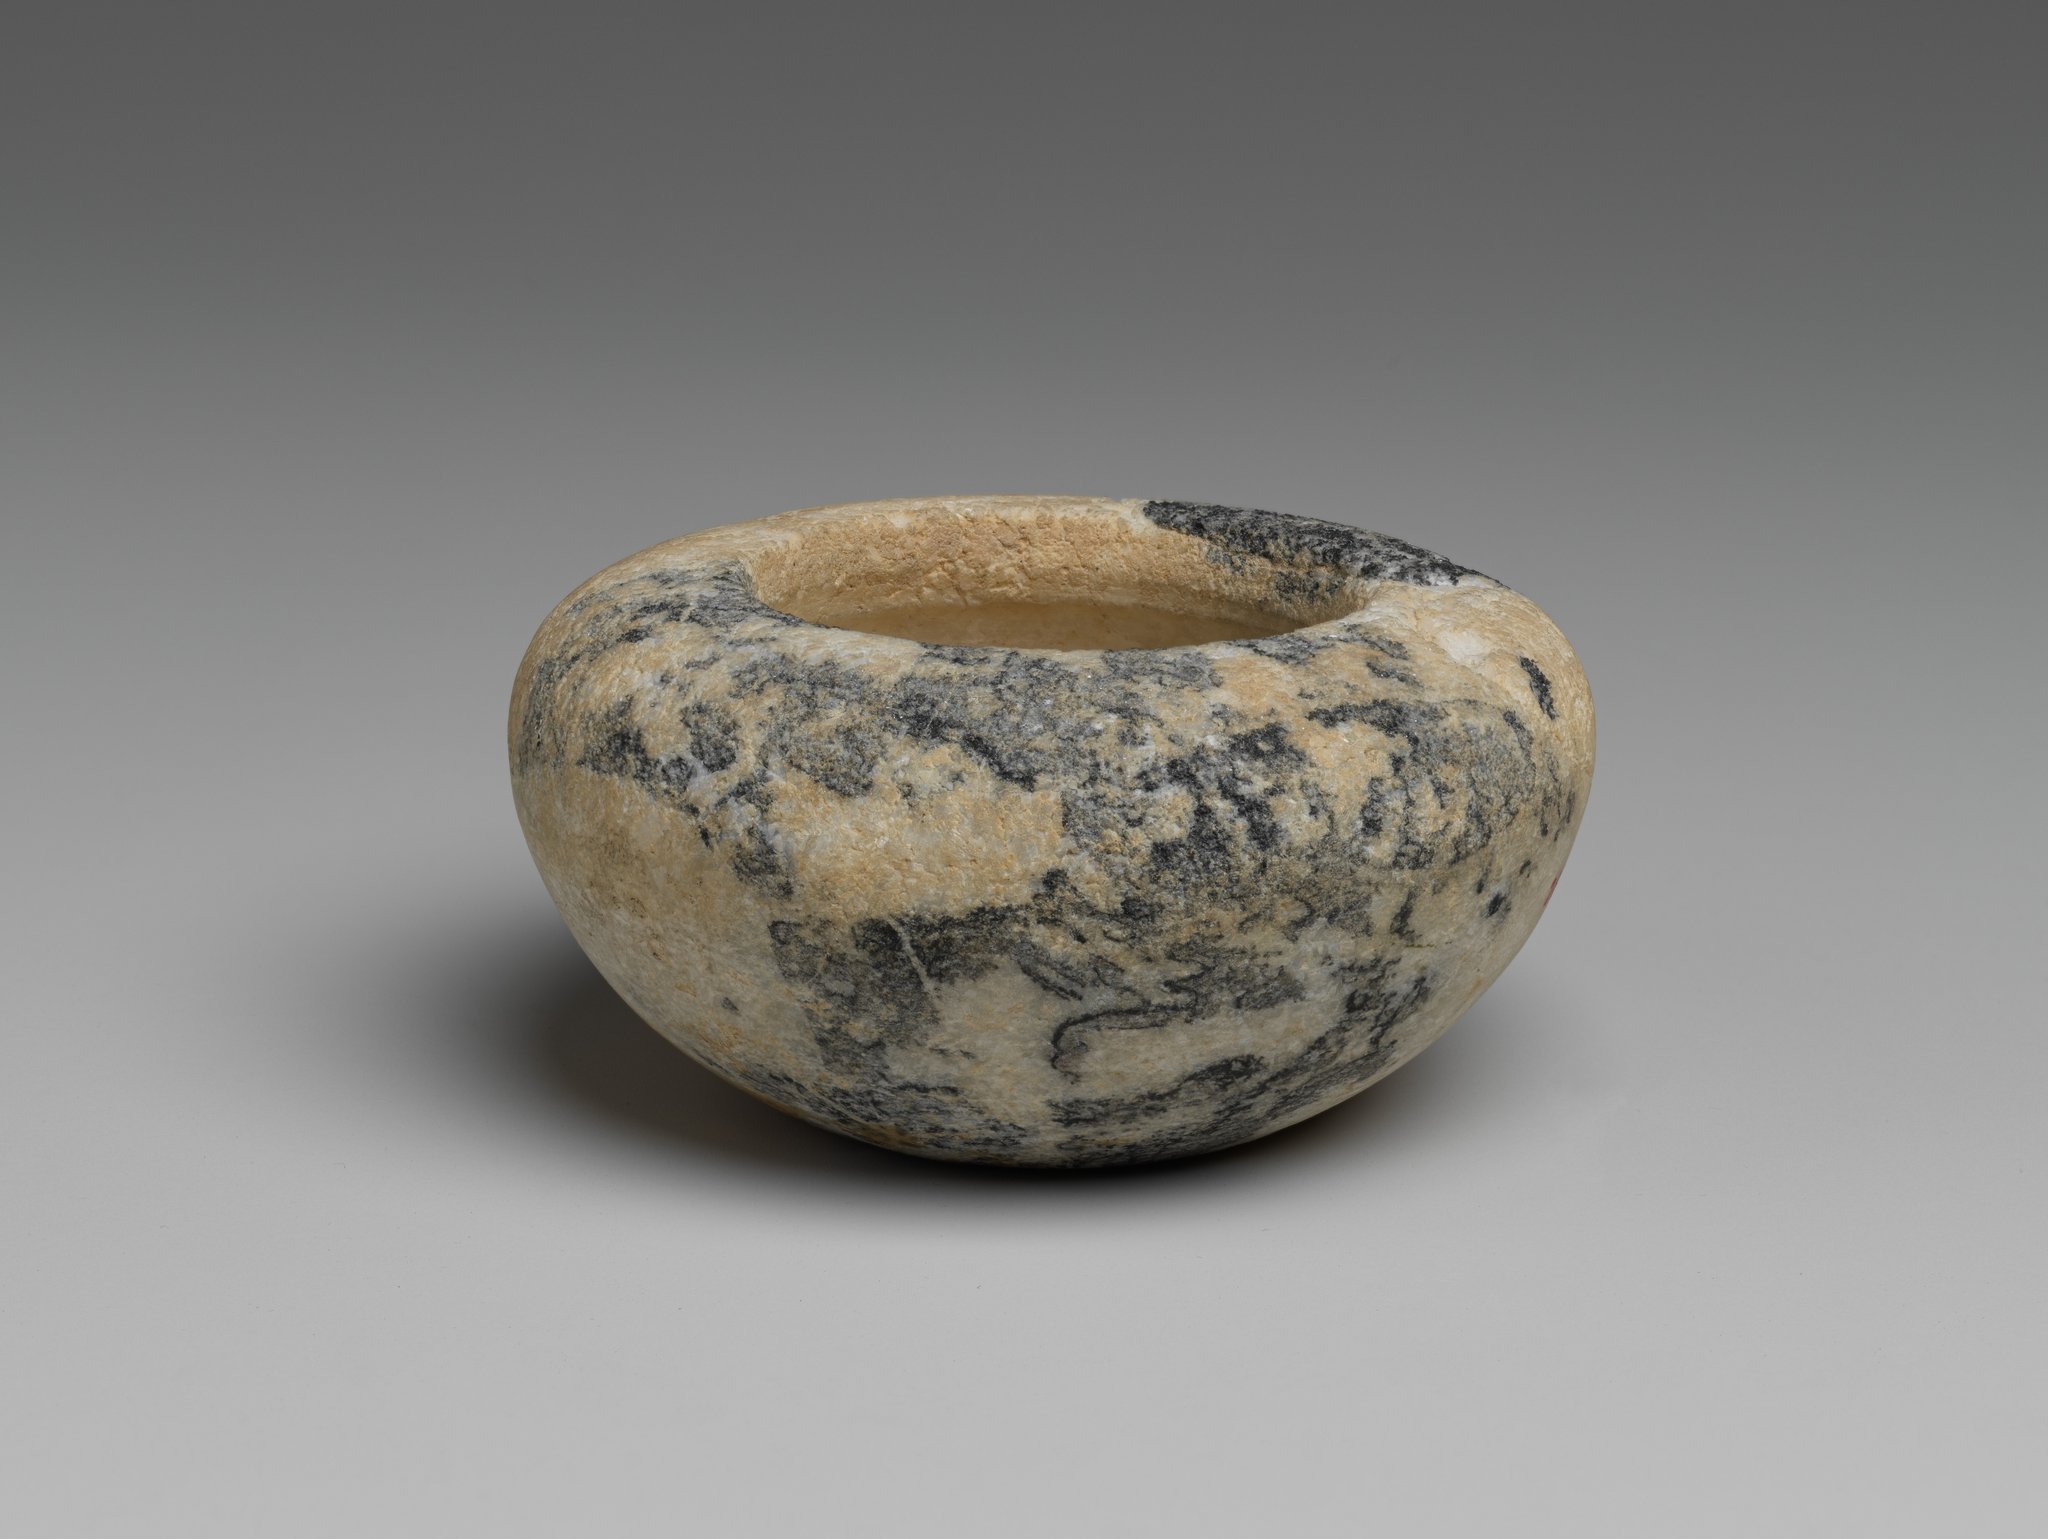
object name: bowl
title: Marble bird's-nest bowl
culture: minoan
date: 1800-1700 BCE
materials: marble